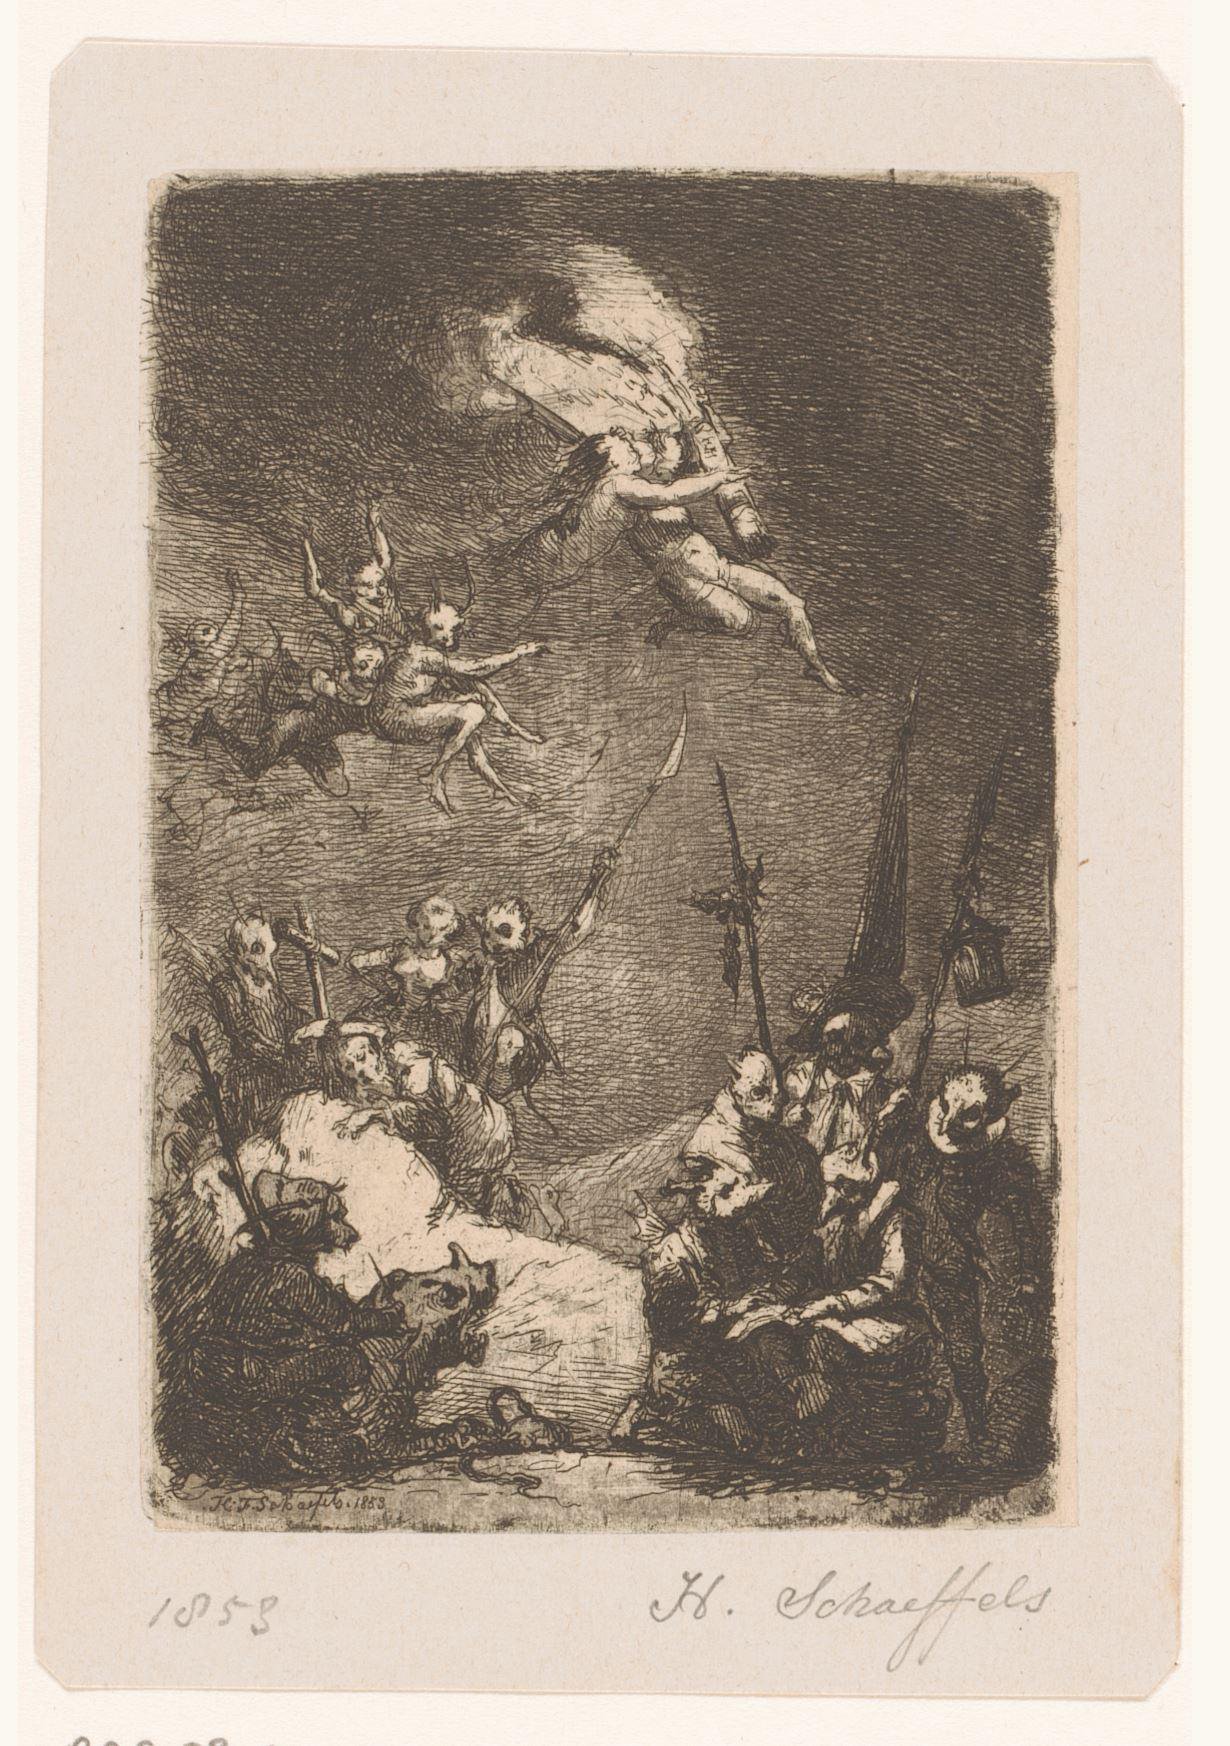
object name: print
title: Demonen proberen Sint-Antonius te verleiden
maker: henri françois schaefels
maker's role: print maker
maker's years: 1827-1904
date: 1853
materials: paper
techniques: aquatint, etching, intaglio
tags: st. antony abbot tormented by devils, attacking him on the ground or carrying him aloft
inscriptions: collector's mark: Lugt 2228